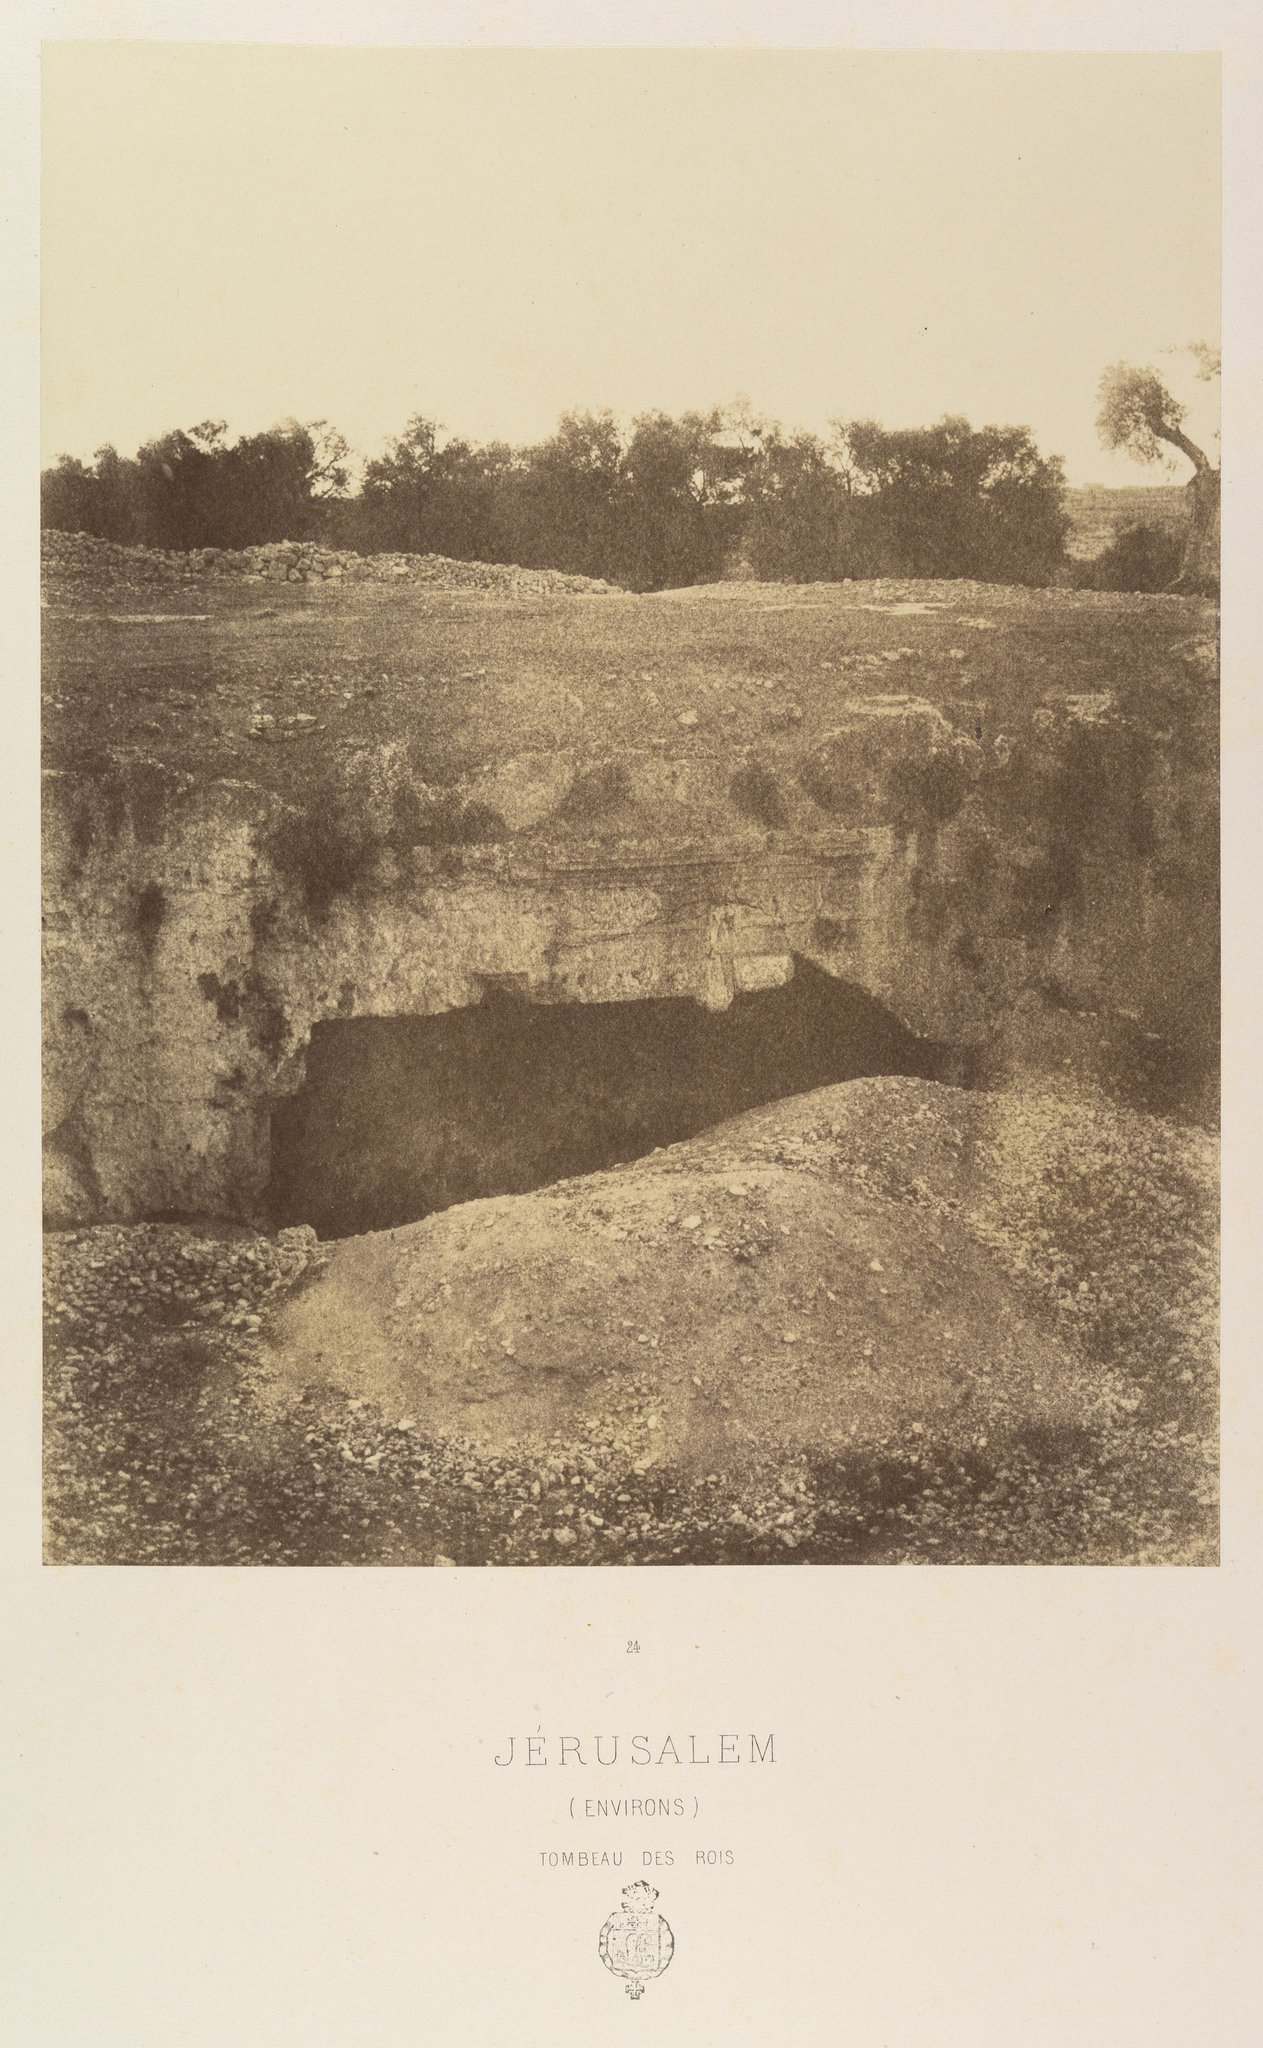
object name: photograph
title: Jérusalem. (Environs) Tombeau des Rois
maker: louis de clercq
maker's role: artist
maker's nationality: french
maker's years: 1837-1901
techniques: albumen silver print, paper negative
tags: tombs